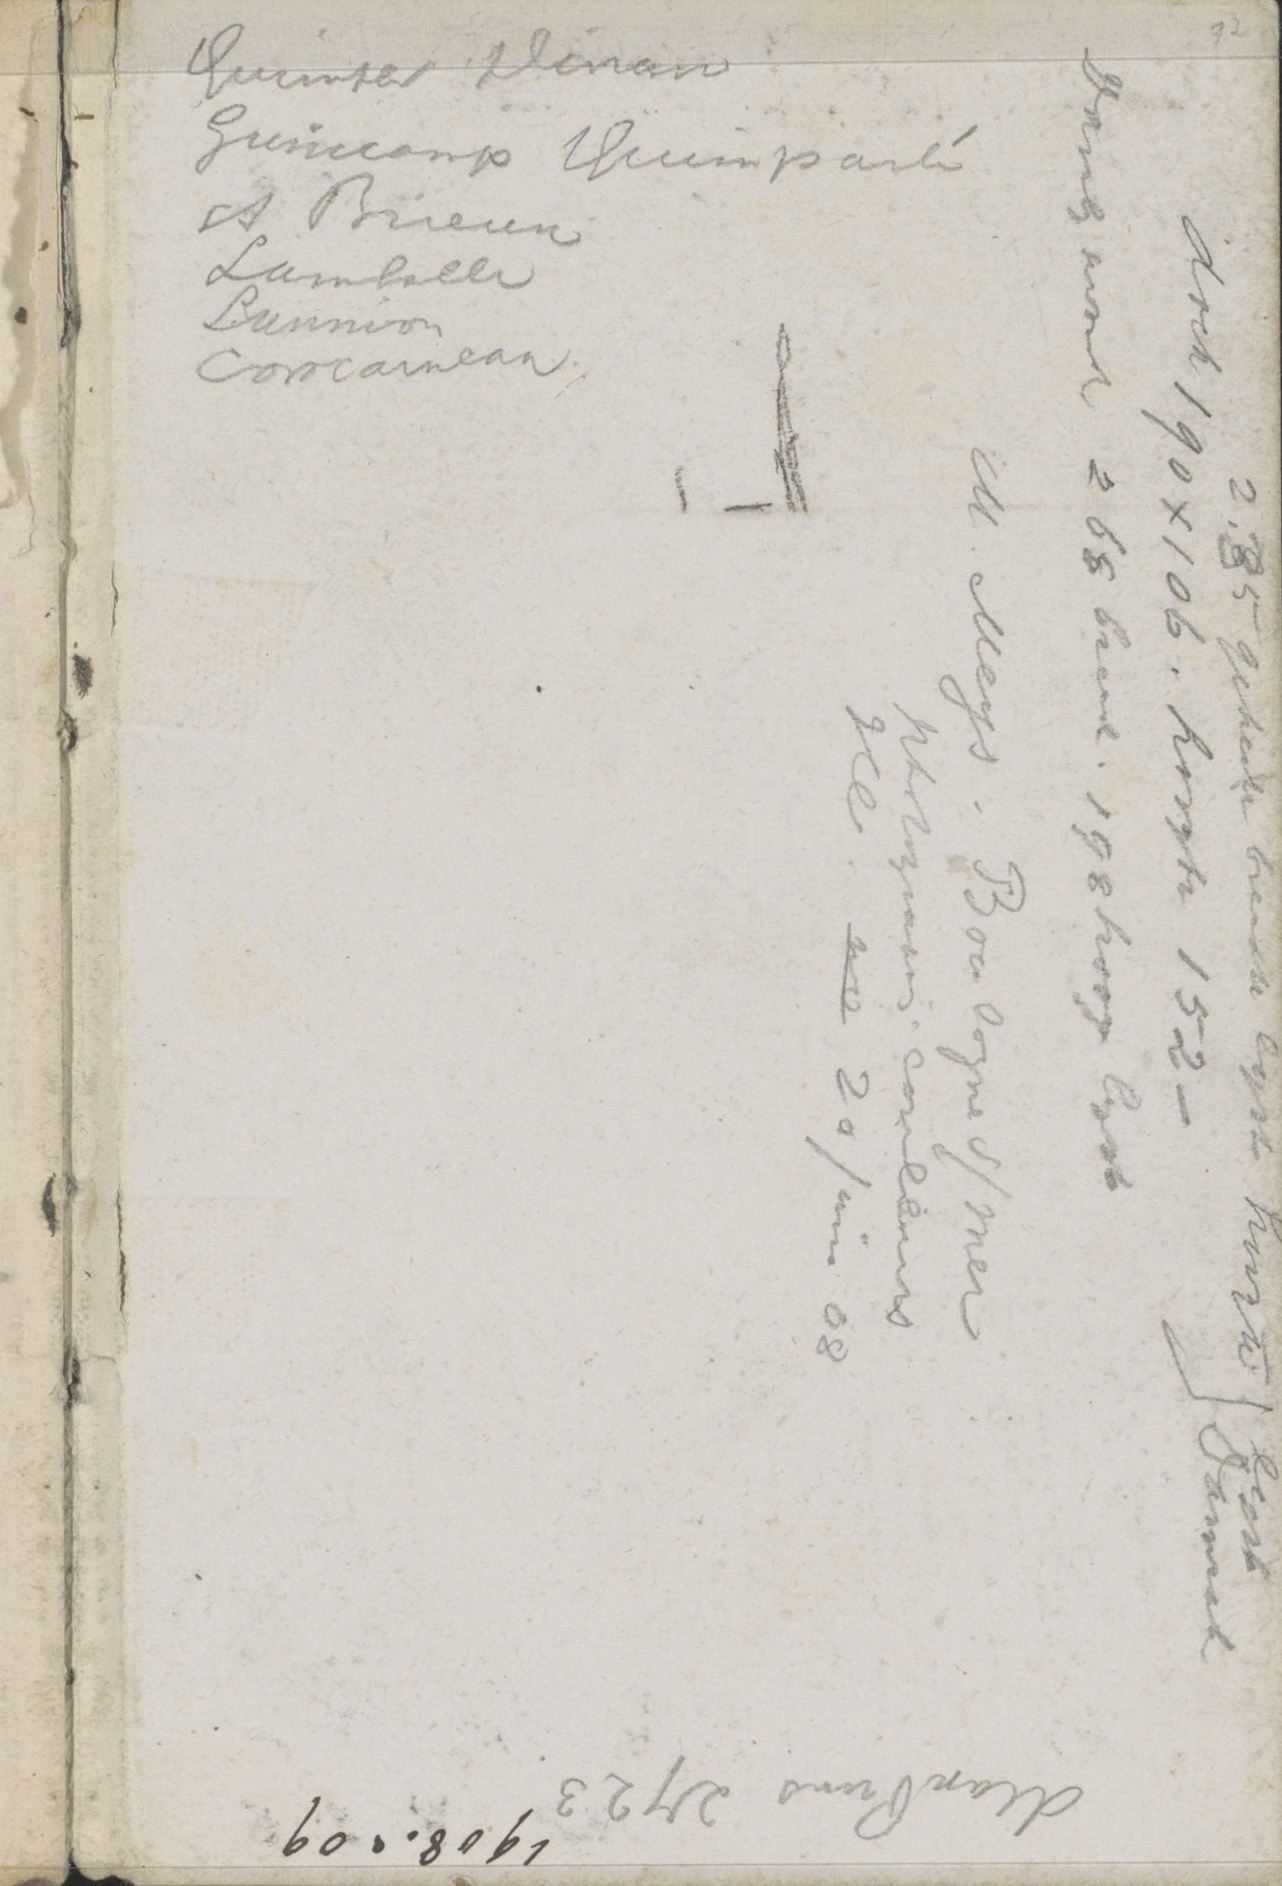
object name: endleaf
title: Annotaties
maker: george hendrik breitner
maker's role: draughtsman, painter, print maker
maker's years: 1857-1923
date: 1907-1909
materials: paper, pencil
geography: amsterdam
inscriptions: address: ‘M. Meys, Boulogne s/ Mer/ [...] couleurs [...]/ wo 20 juin 08’, annotation: ‘2.35 geheele breedte lijst hoogte lijst/ Damrak/ doek 190 x 106. hoogte 152-/ Dansavond 265 breed. 198 hoog lijst’, annotation: ‘[...] Concarneau’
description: Aantekeningen. Pagina 92 uit een schetsboek met 46 bladen vervaardigd te Antwerpen, Gent en Amsterdam.